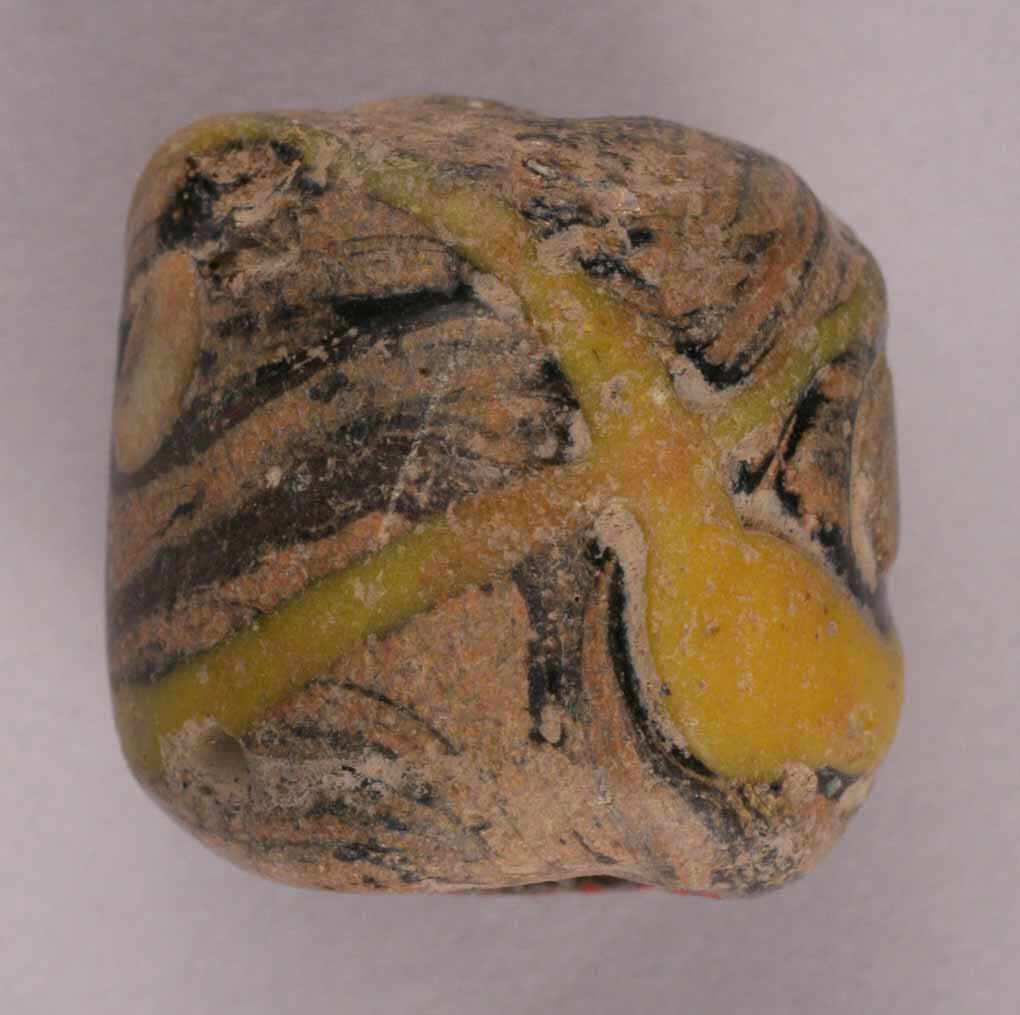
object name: bead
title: Beads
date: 701-1000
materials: glass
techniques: luster painting, stain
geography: iran